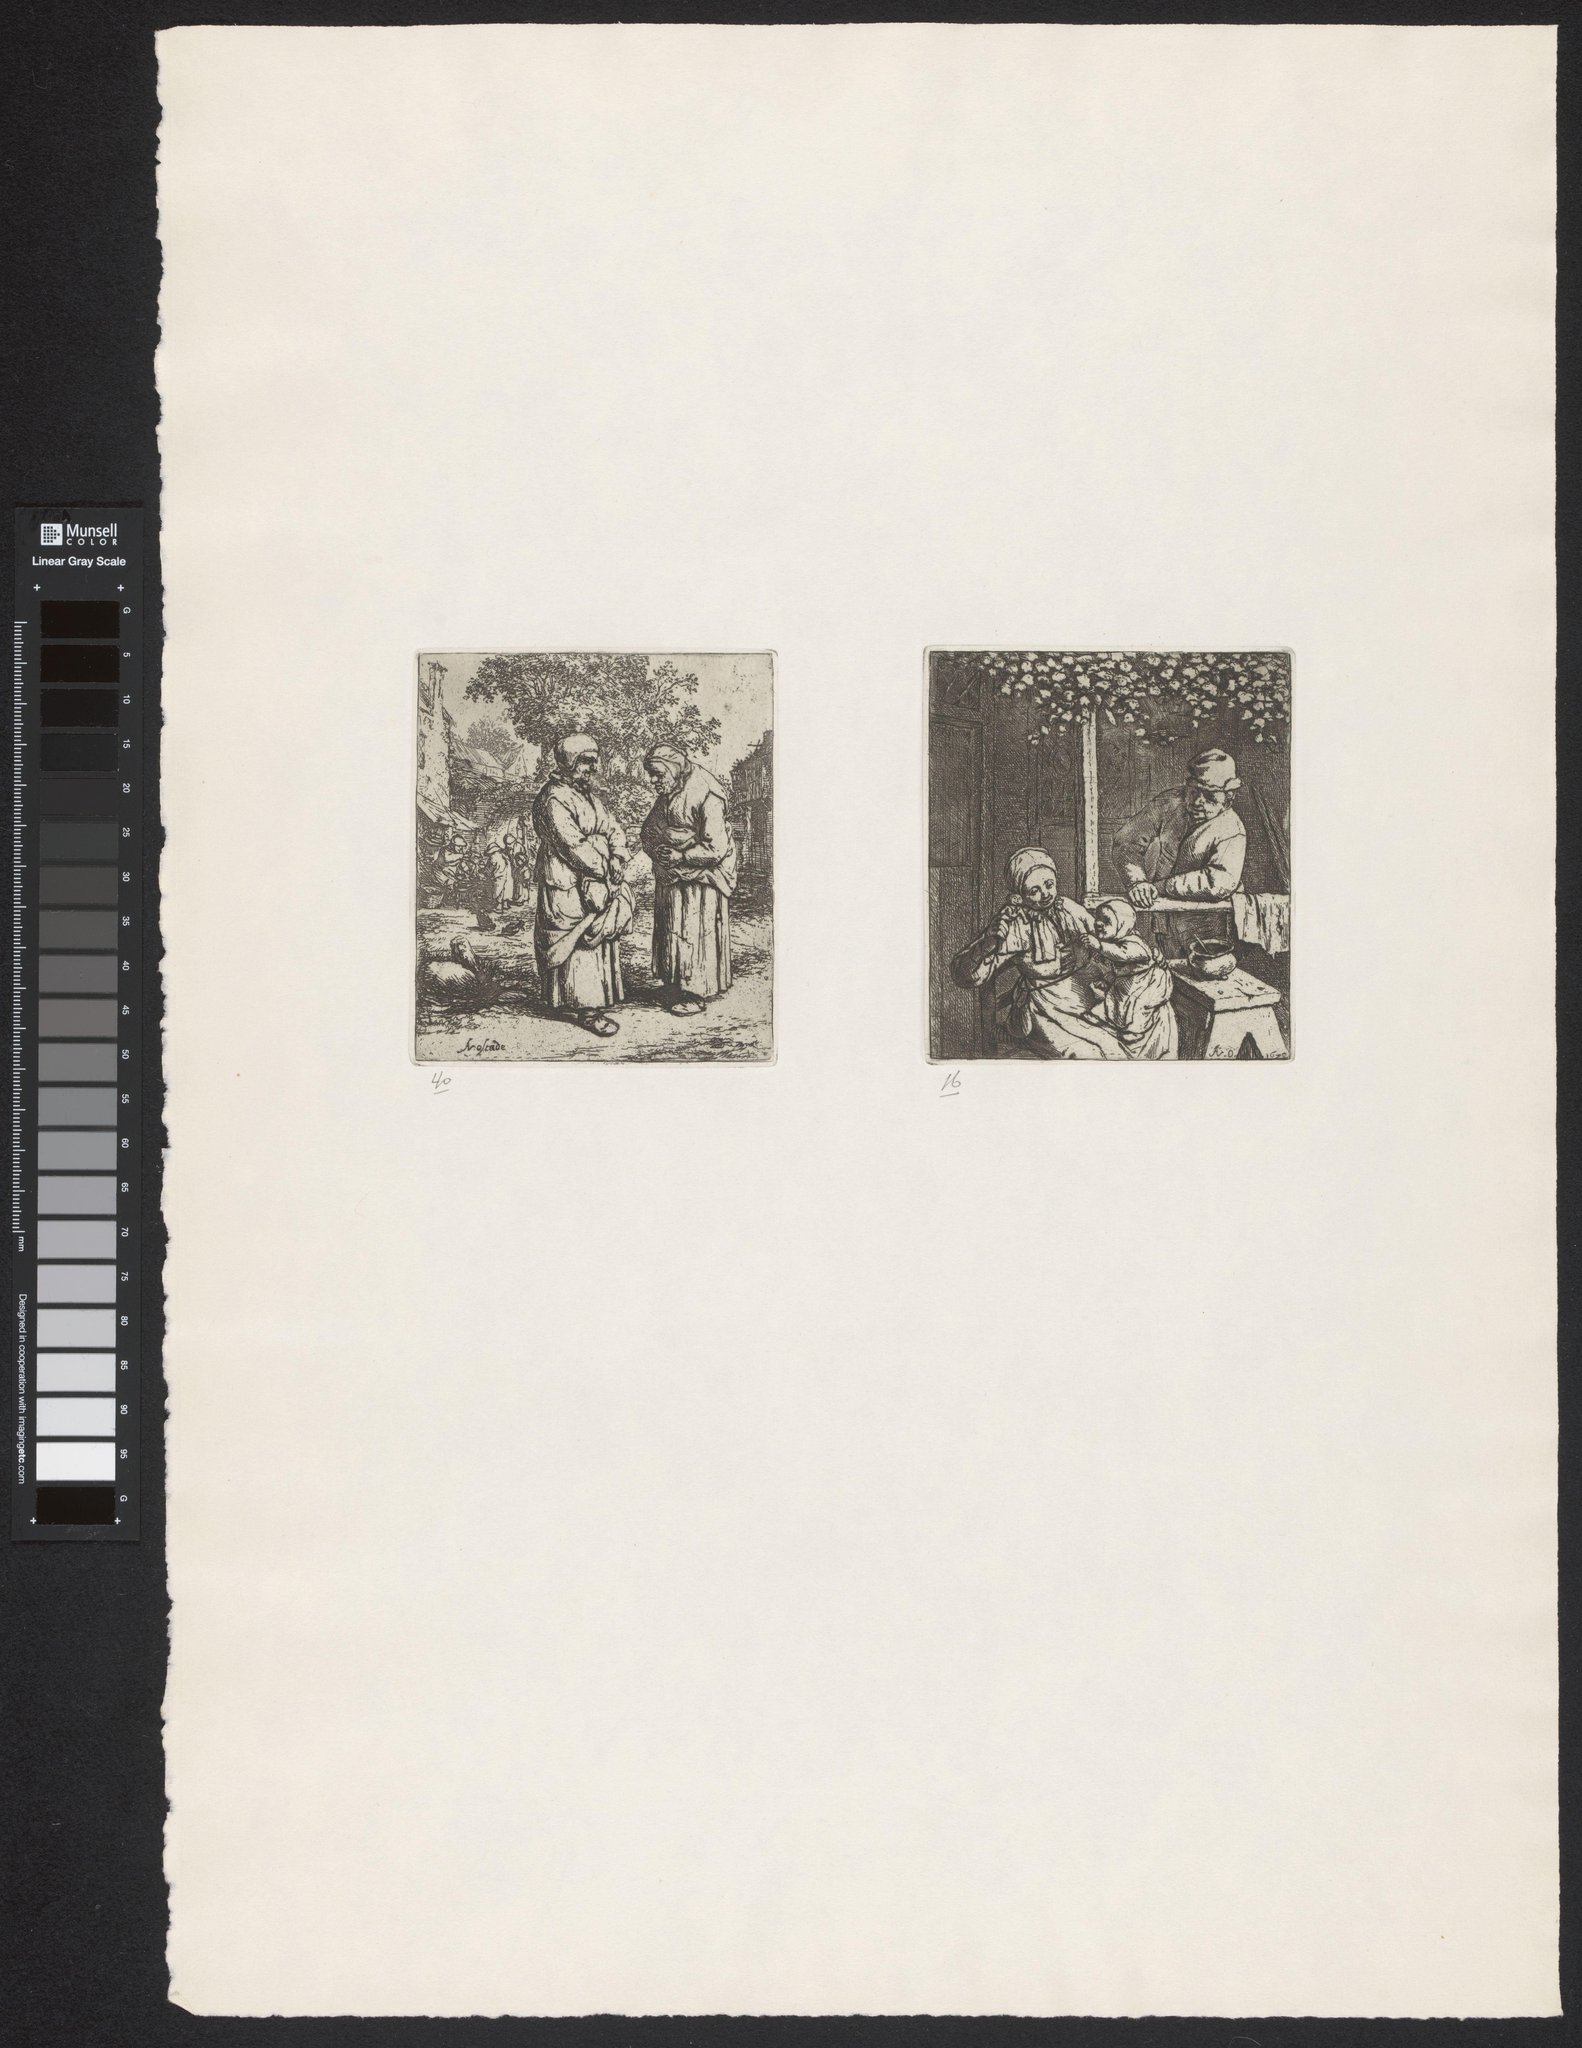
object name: album leaf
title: Man kijkt in lege kruik, twee mannen kijken toe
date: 1651-1655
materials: paper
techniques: etching, galvanization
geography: haarlem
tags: inn, coffee-house, public house, etc., drinking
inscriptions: collector's mark: ‘B’, collector's mark: ‘RIJKS / MUSM’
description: Enkele gebaren van de mannen in deze voorstelling dragen een negatieve betekenis. De man die in de lege kruik kijkt is een kannekijker ofwel een dronkaard. Het gebaar van de staande man achter hem, met zijn hand verstopt achter zijn hemd, werd in verband gebracht met luiheid. De prent maakt deel uit van een portefeuille en is met een andere prent op één albumblad gedrukt.